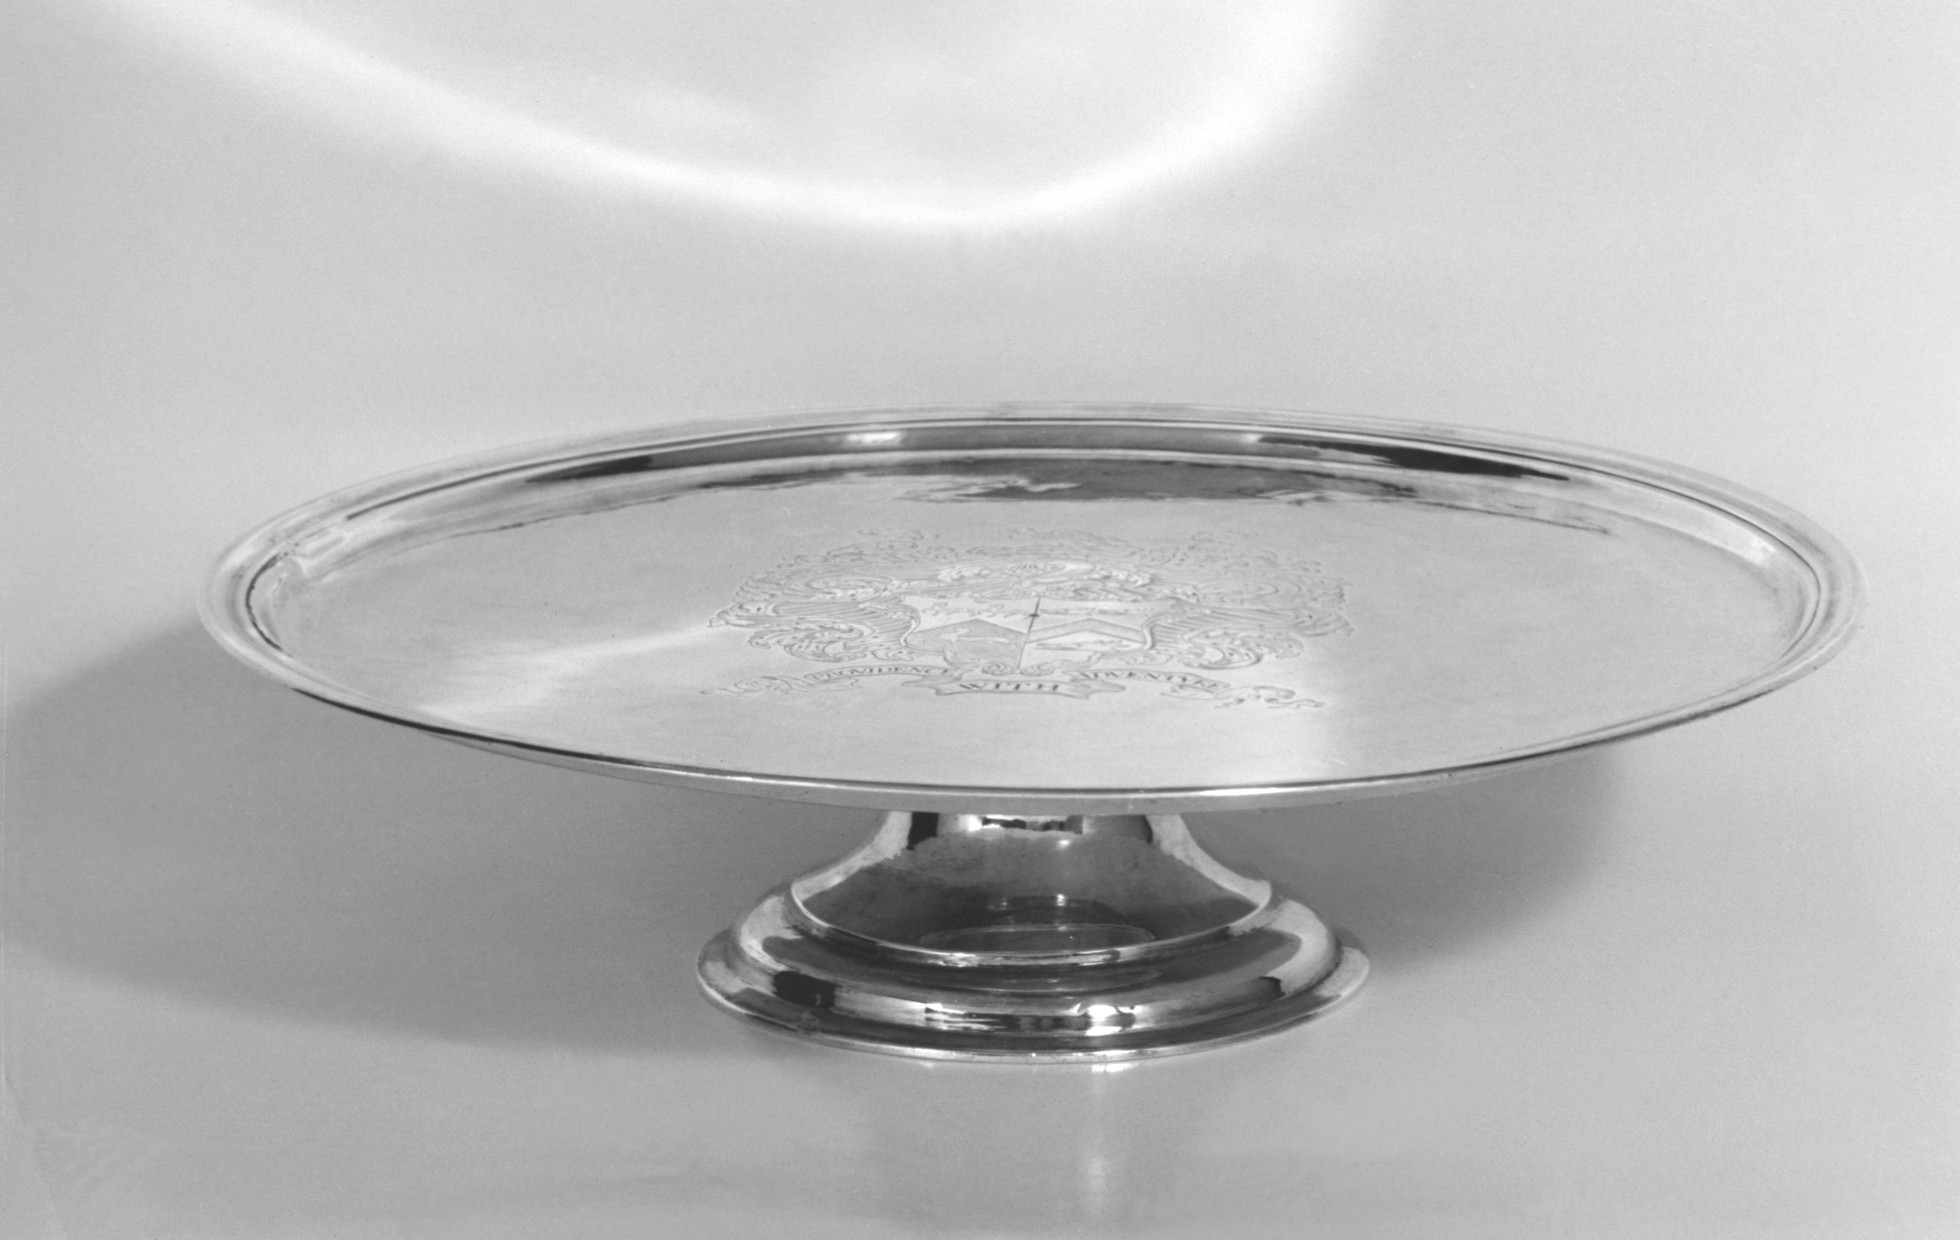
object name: salver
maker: david king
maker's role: maker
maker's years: 1688-1738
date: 1710-1712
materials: silver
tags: birds,coat of arms